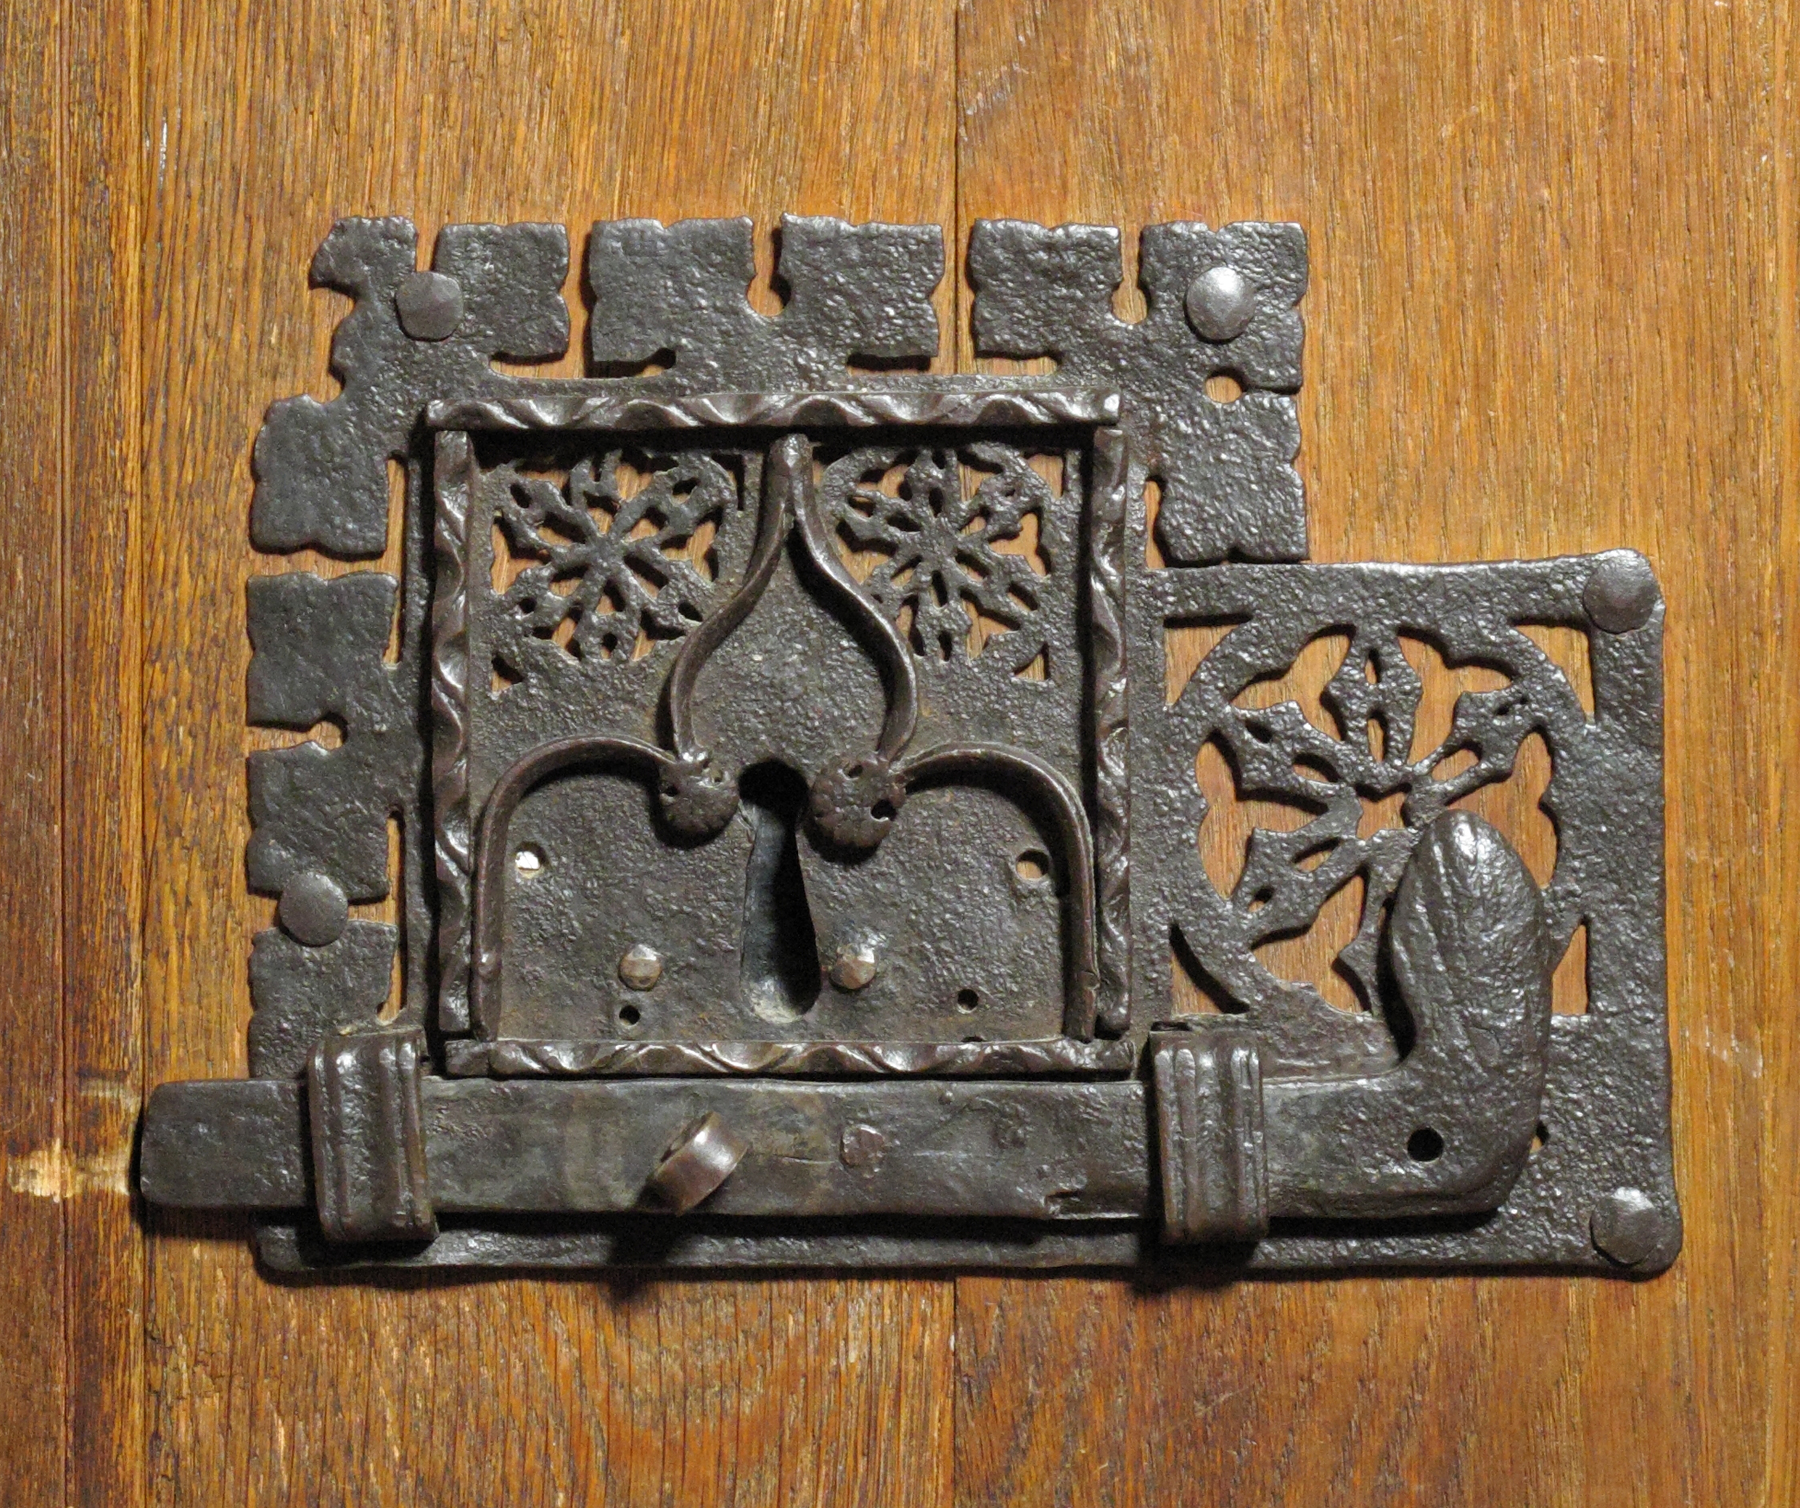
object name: lock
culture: european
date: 1401-1600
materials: iron